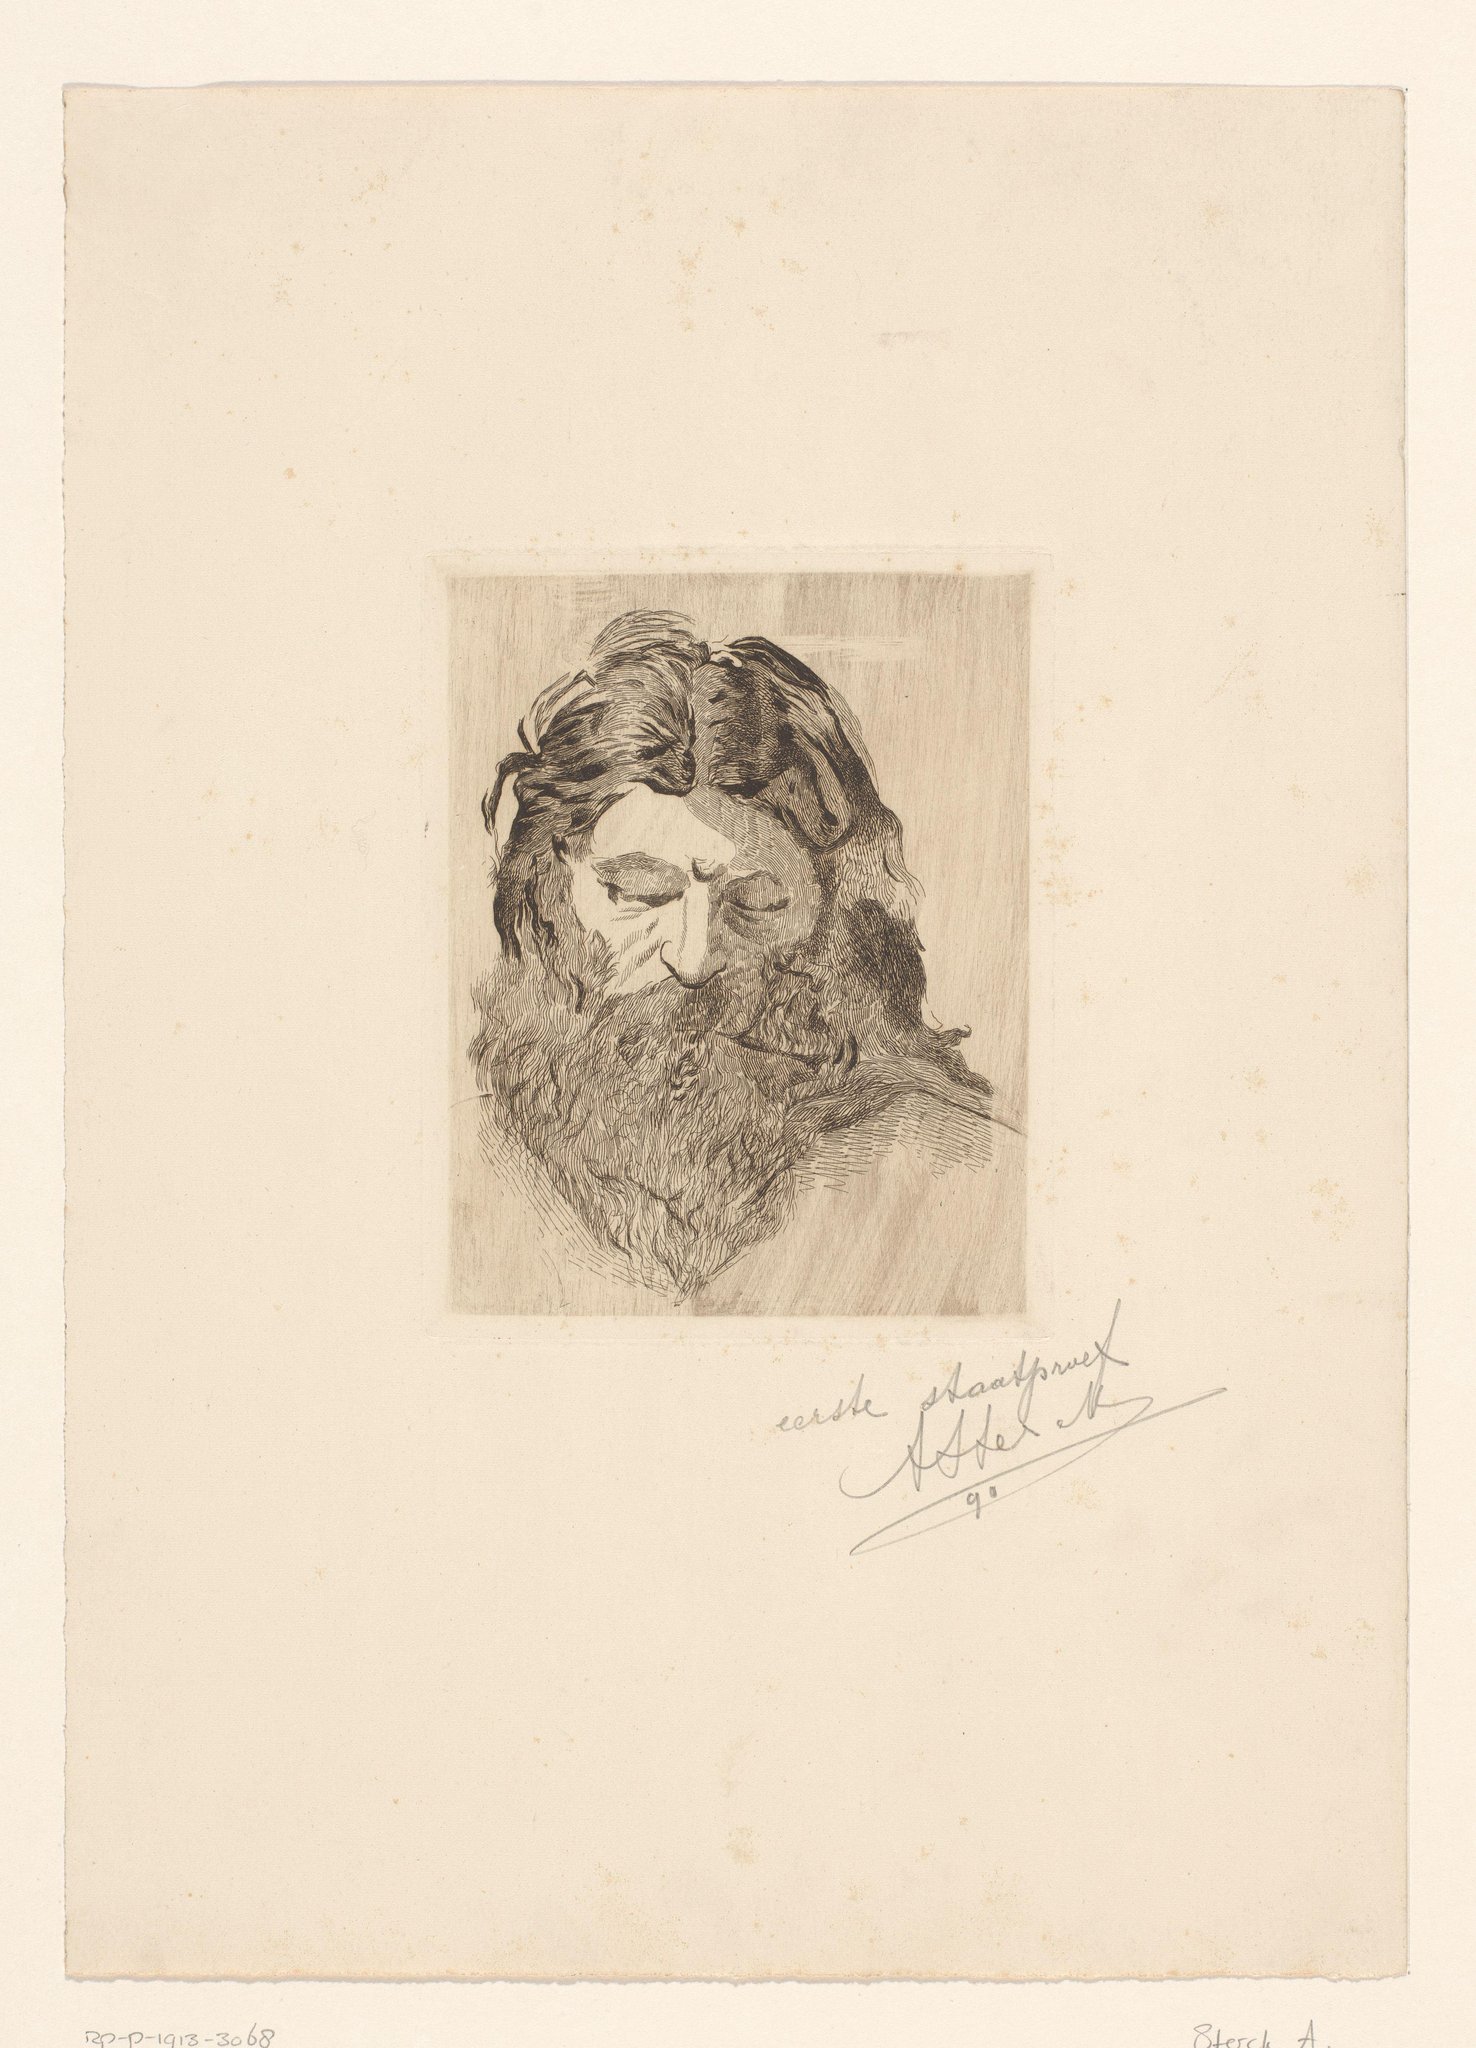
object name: print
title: Portret van een onbekende man met baard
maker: arthur sterck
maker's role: print maker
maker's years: 1868-1897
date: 1890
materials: paper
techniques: drypoint, etching, intaglio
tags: anonymous historical person portrayed alone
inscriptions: collector's mark: Lugt 2228, annotation: ‘eerste staatproef’